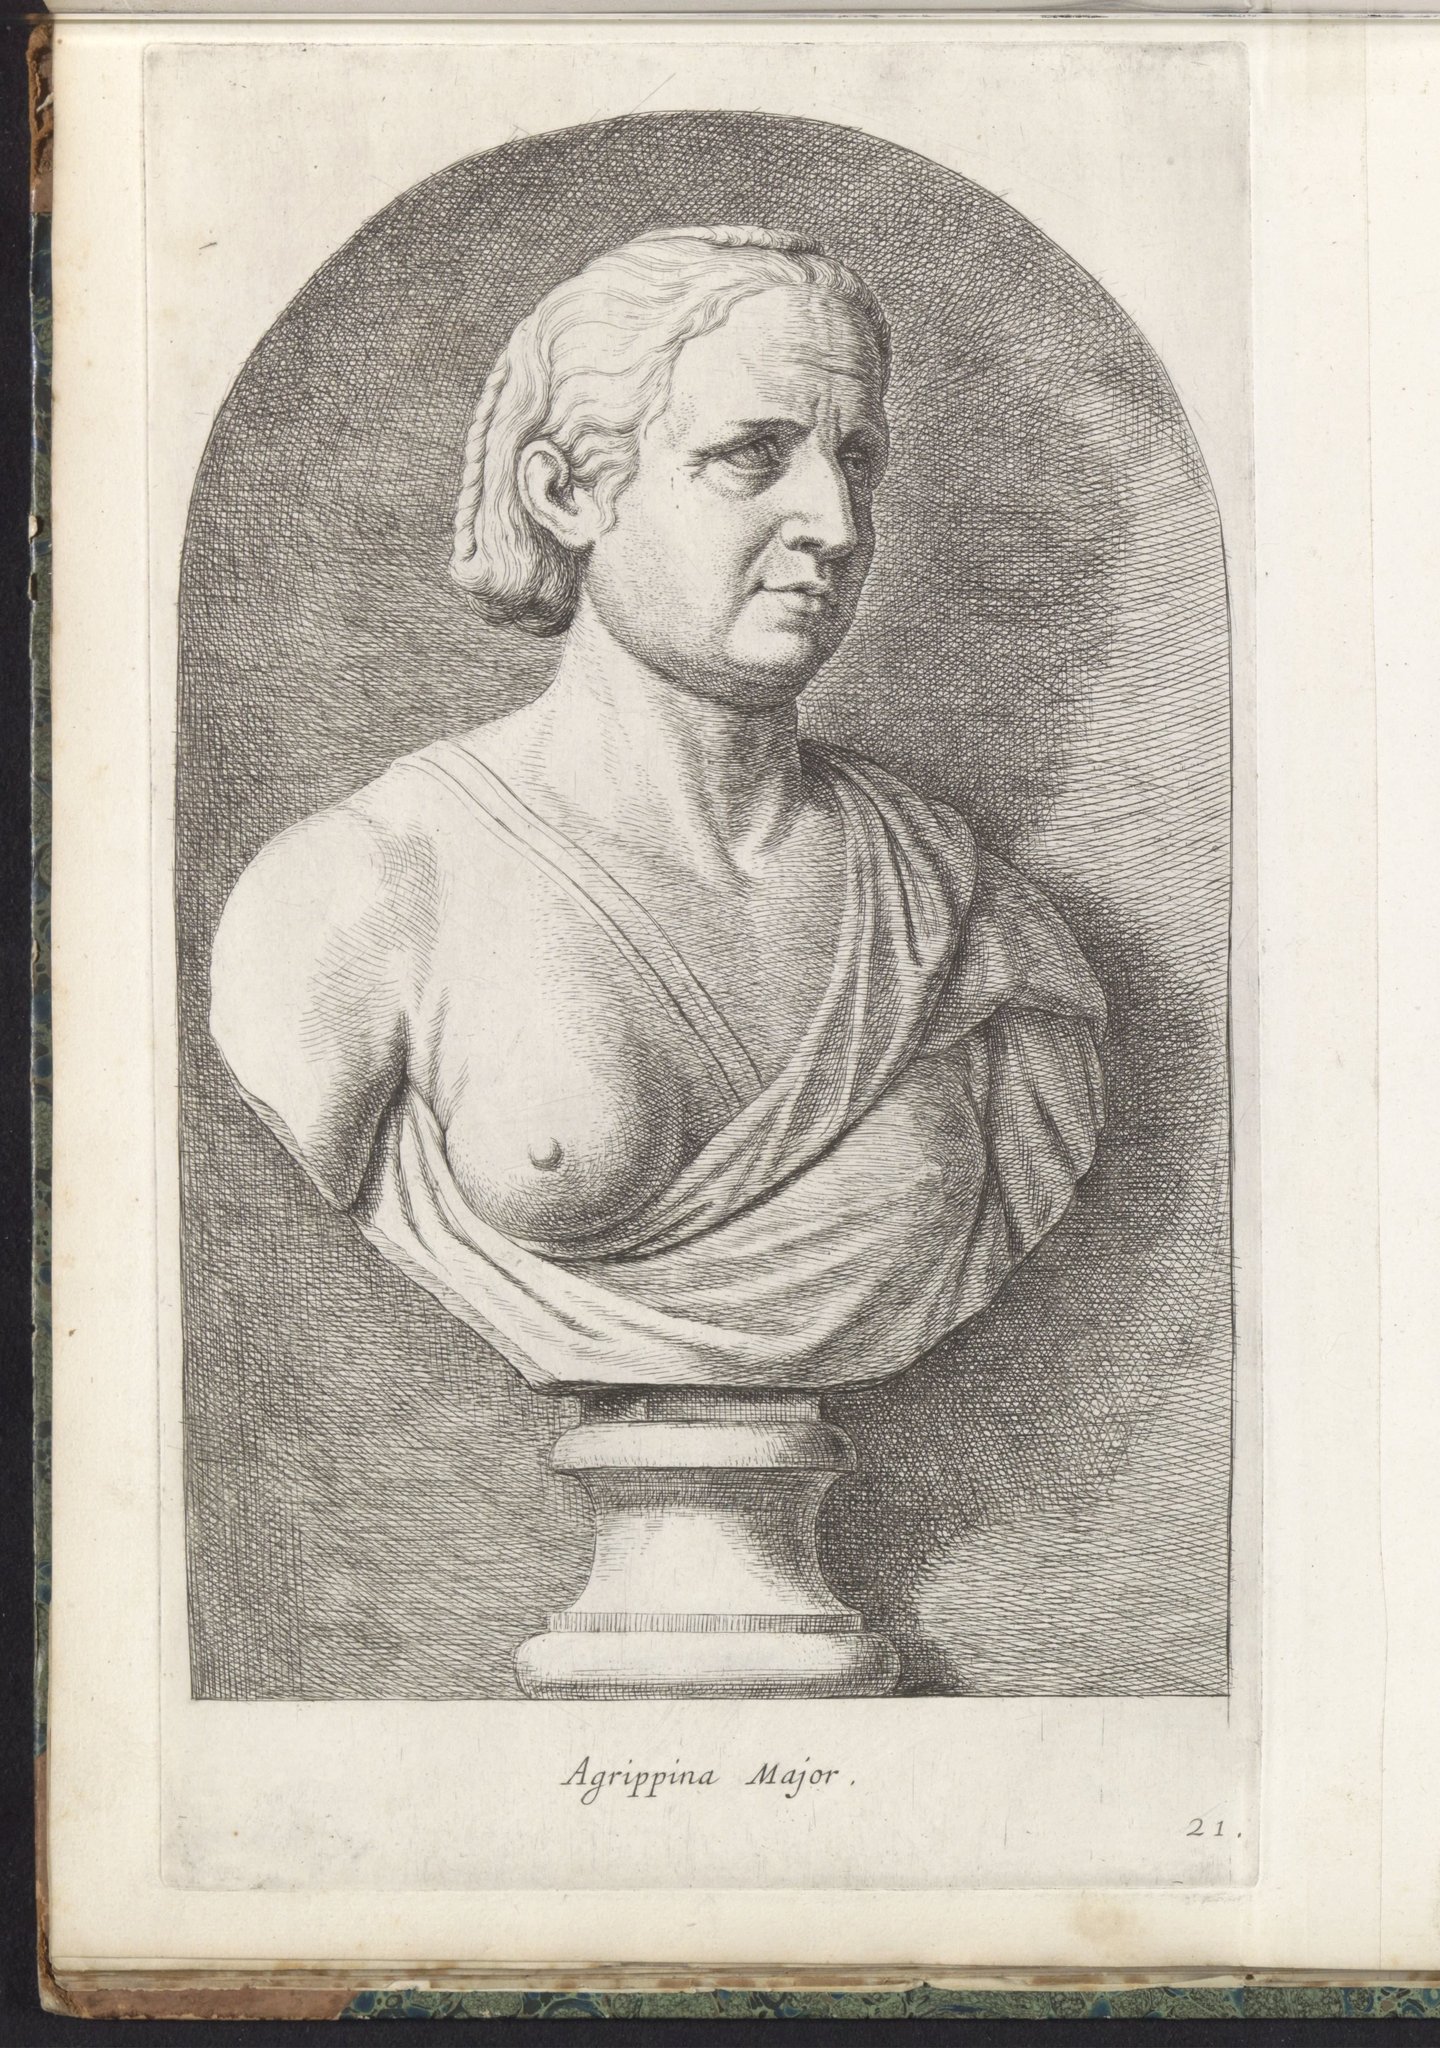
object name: album leaf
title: Agrippina Major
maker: hubert quellinus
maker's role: print maker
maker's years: 1619-1687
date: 1646-1670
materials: paper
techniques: engraving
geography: antwerp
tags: piece of sculpture, reproduction of a piece of sculpture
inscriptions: number: ‘50’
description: Klassieke buste van een vrouw met ontblote borst. De prent maakt deel uit van een album met een serie prenten naar de sculpturen in de verzameling van Gerard Reynst.